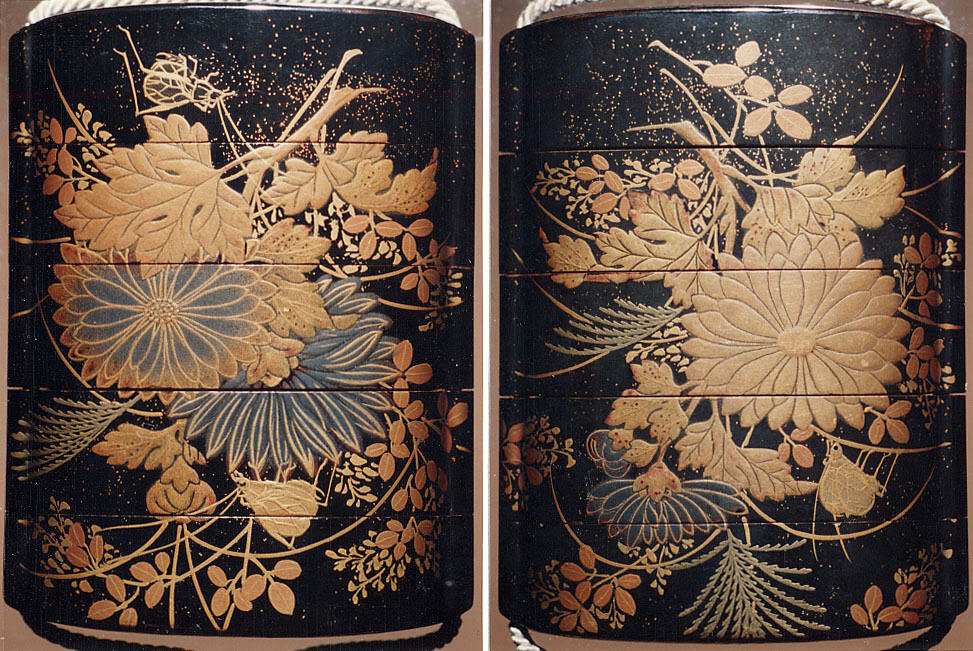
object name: inrō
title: Case (Inrō) with Design of Insects beside Flowering Autumn Grasses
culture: japanese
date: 1701-1800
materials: gold, lacquer, silver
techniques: fundame, hiramakie, roiro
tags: insects,flowers